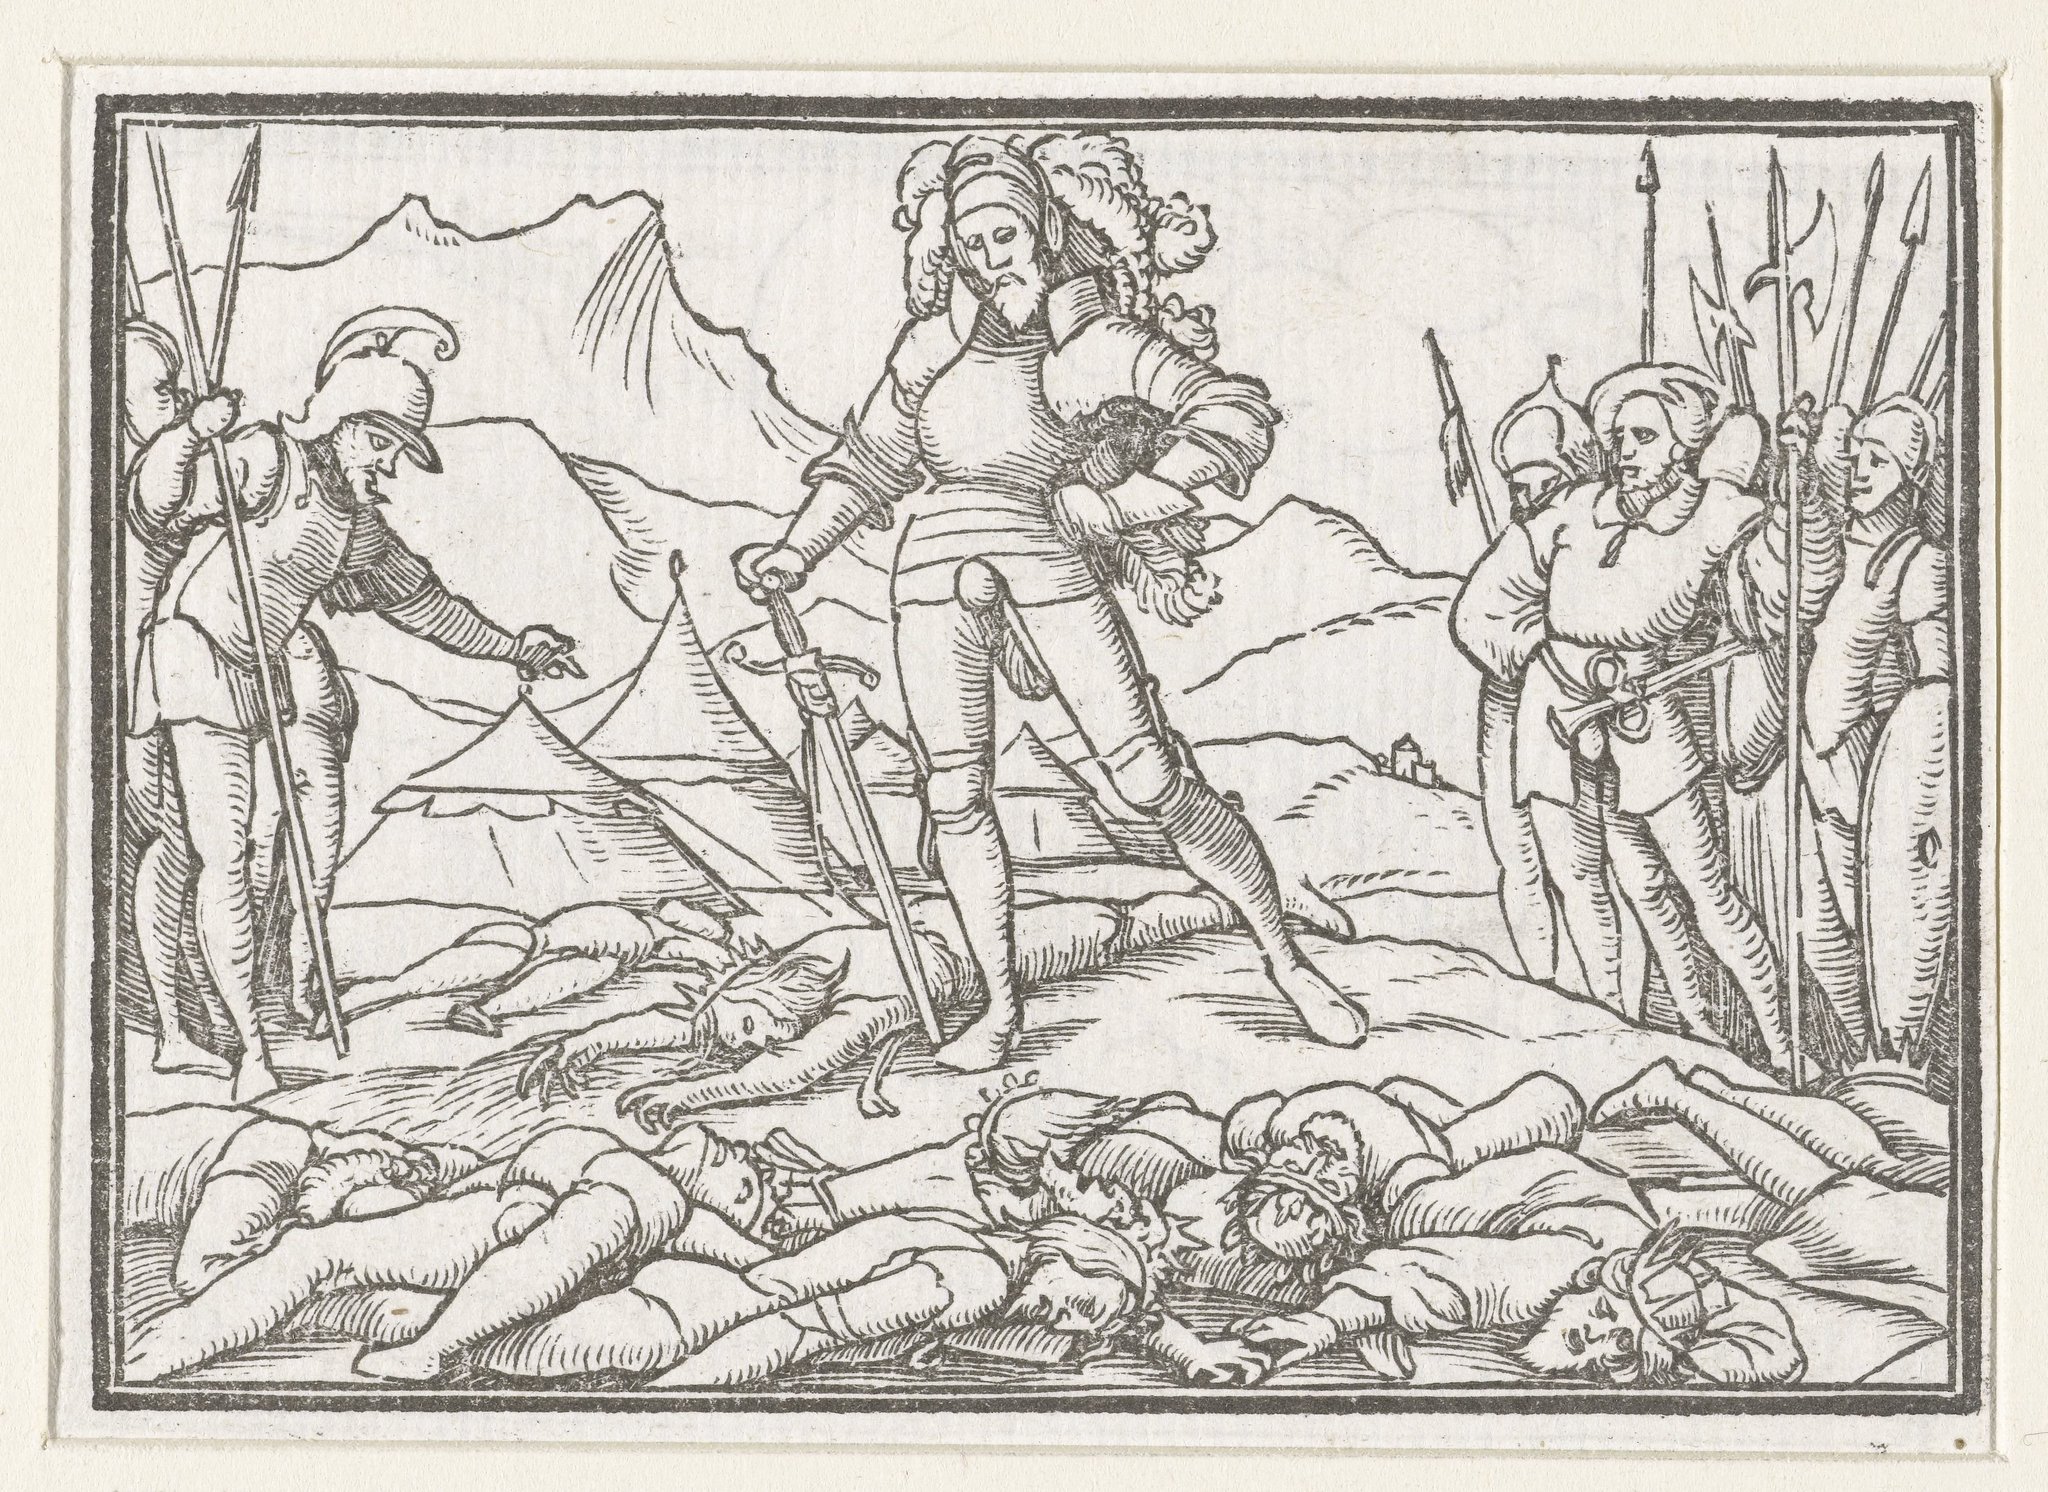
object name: book illustration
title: Jozua als legeraanvoerder van Israëlieten met lichamen van de verslagen koningen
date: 1538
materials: paper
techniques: woodcut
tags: the territory of the thirty-one kings is conquered by joshua and his army (joshua 12:7-24)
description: Jozua staat als legeraanvoerder van de Israëlieten bij de dode lichamen van de verslagen koningen. Links en rechts staan mannen uit het leger. In de marge boven de afbeelding staat de tekst Josva XII.